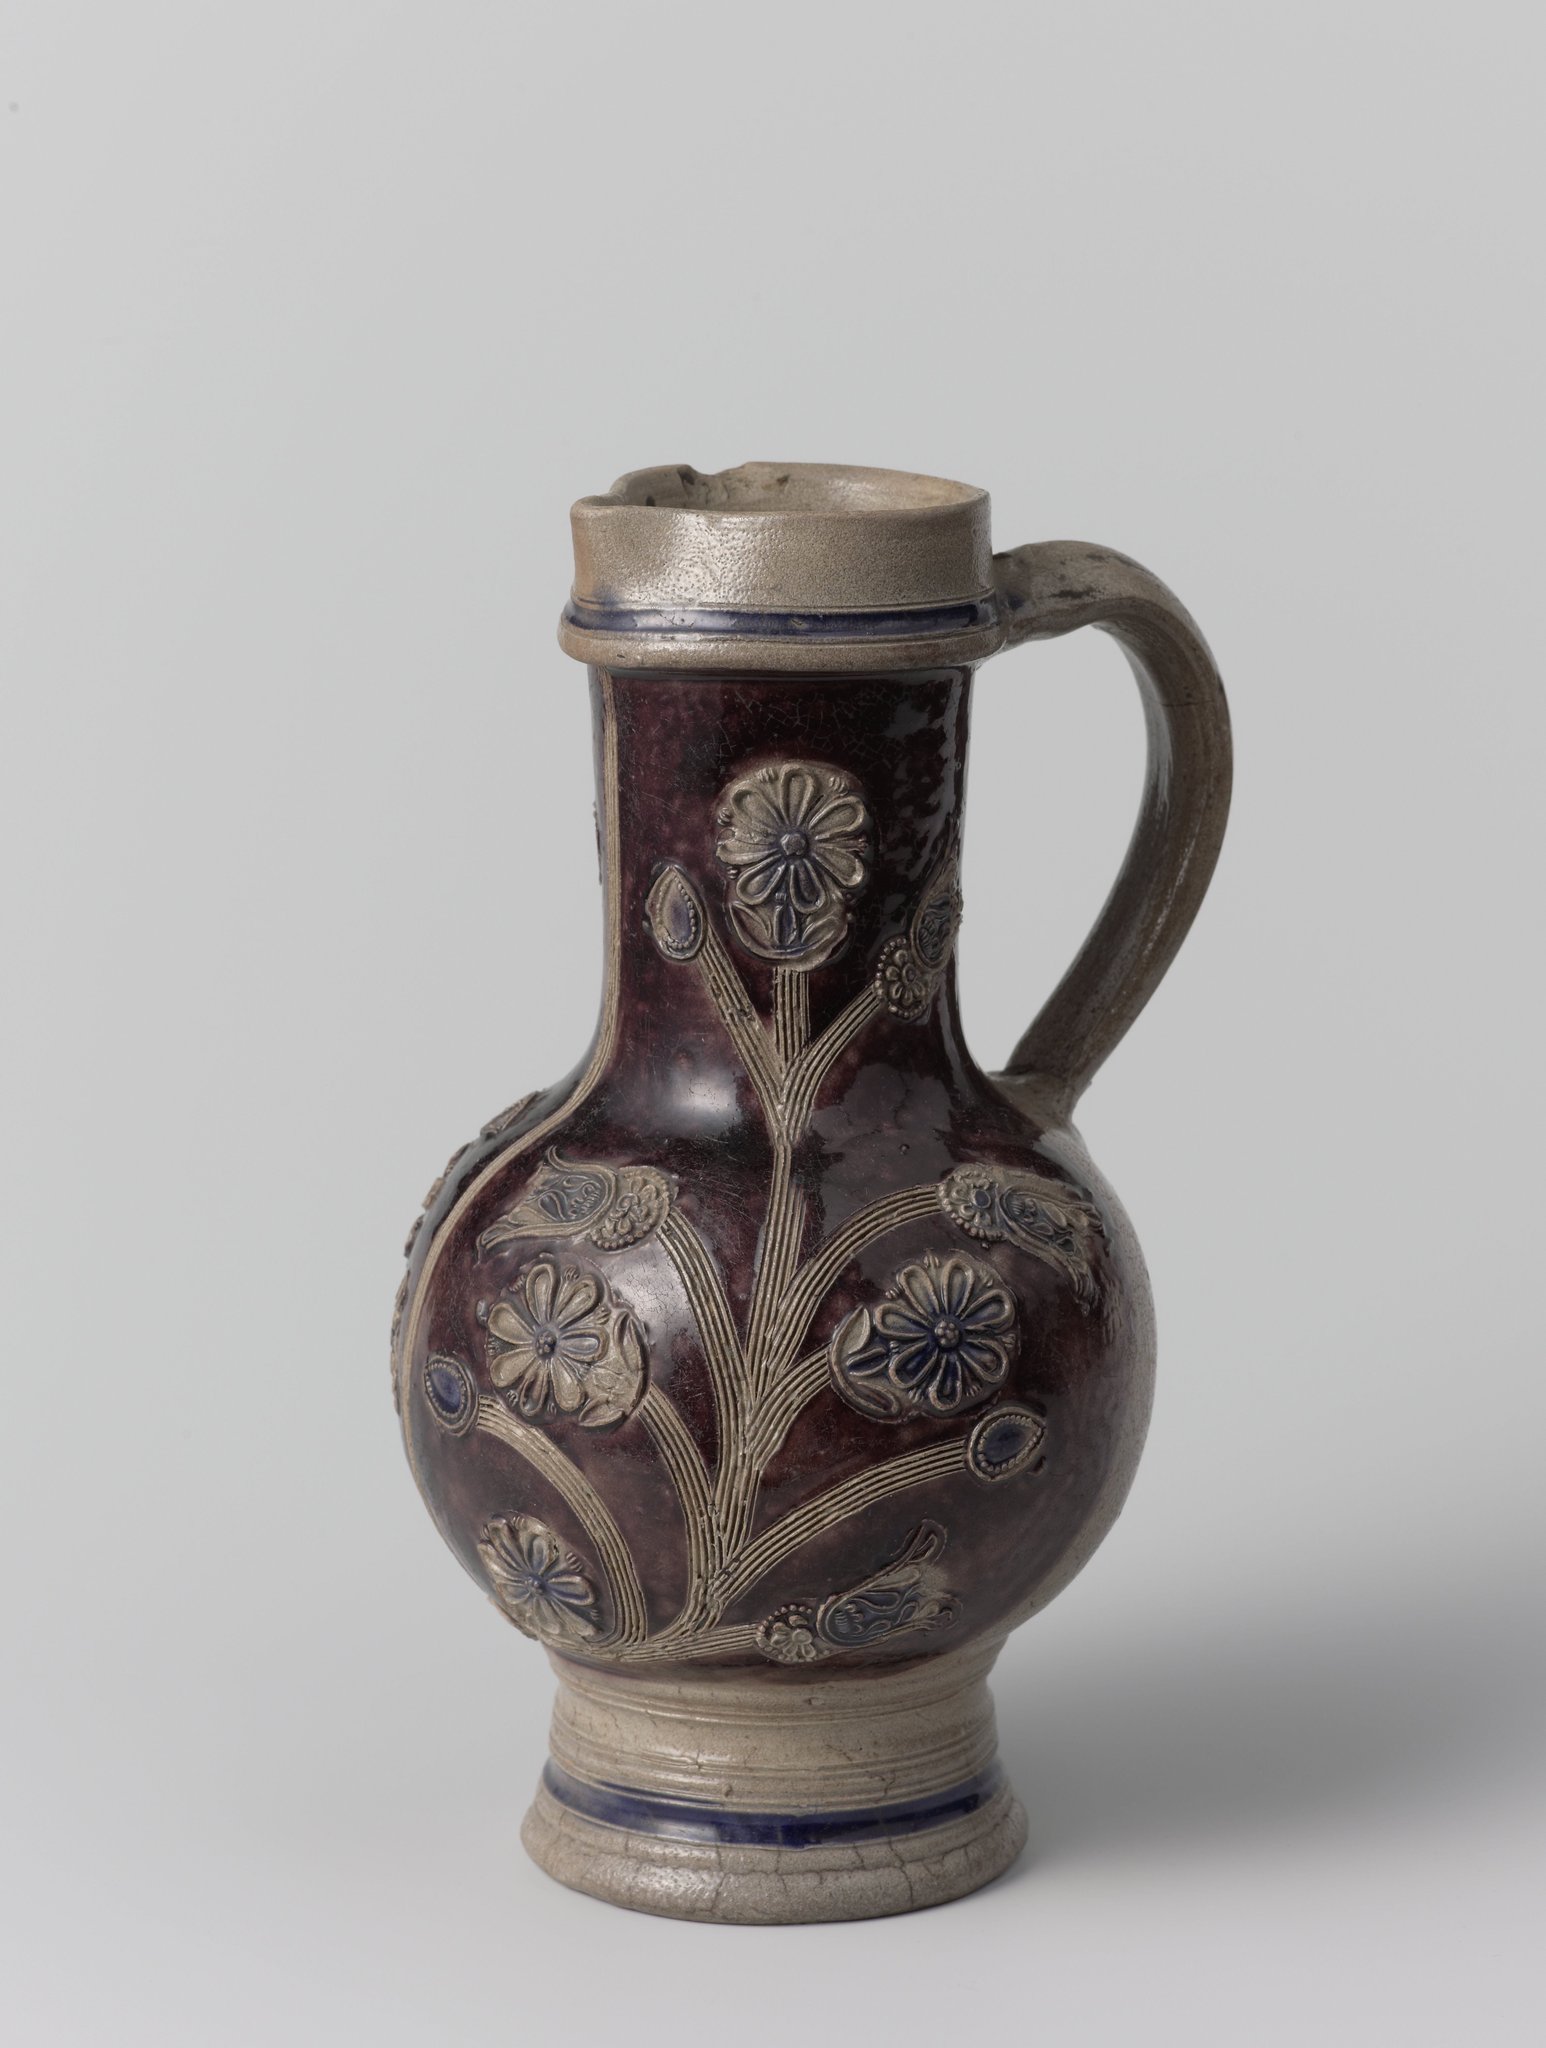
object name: ewer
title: Jug with floral scrolls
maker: Anonymous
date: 1650-1749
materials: cobalt, glaze, mineral, stoneware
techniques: firing, forming, relief, turning, vitrification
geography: westerwald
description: Kan van steengoed op hoge voet met een bolvormig lichaam en smalle, lange nek met een geknepen tuit. Het C-vormige oor is bevestigd aan de nek en de schouder. Op de nek een profiel en enkele ingegrifte lijnen op de voet. Gedeeltelijk bedekt met kobaltblauw en mangaanpaars. De voorzijde van de kan twee vakken met een bloeiende plant bestaande uit ingegrifte ranken uitgespaard in een paarse achtergrond. De bloemen zijn gedrukt, opgelegd en met blauw gekleurd. Westerwald.